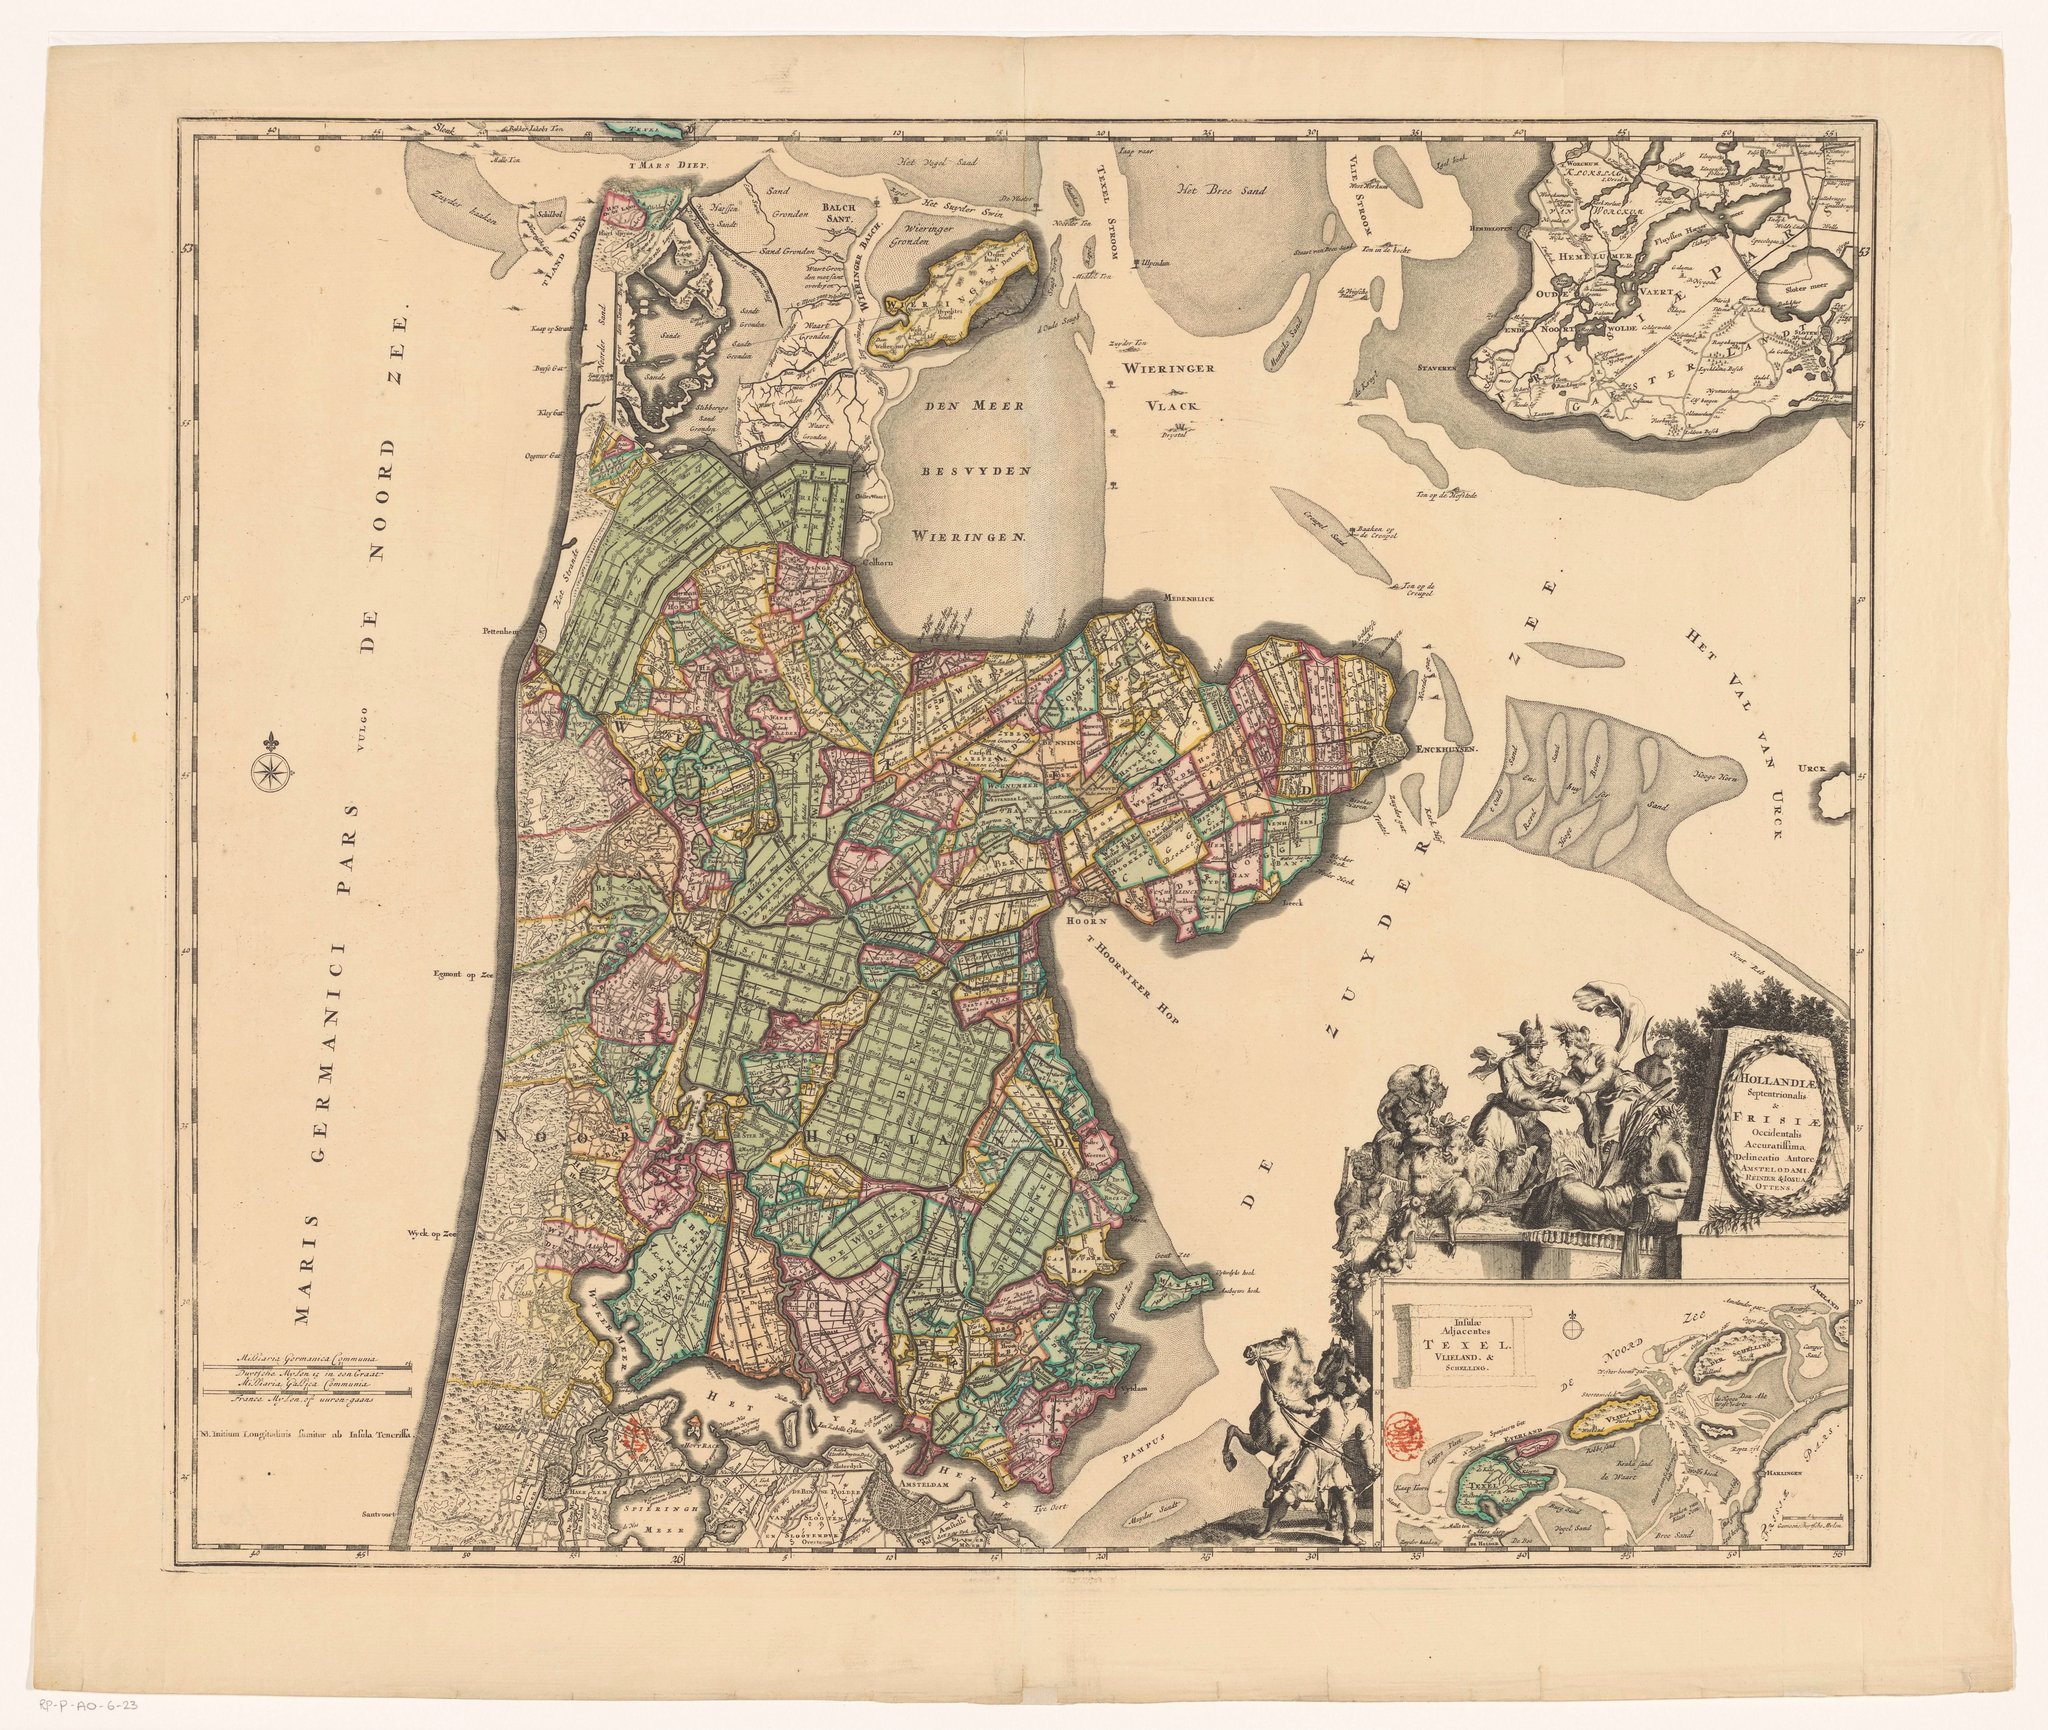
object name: map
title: Kaart van Noord-Holland en een deel van Friesland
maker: Anonymous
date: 1726-1750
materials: paper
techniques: engraving, etching, hand coloring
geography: amsterdam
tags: 'cornucopia', horn of plenty, maps of separate countries or regions, (story of) mercury (hermes), river-gods, satyr(s) (in general)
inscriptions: collector's mark: Lugt 195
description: Linksonder twee schaalstokken: Milliaria Germanica communia / Duytsche mylen 15 in een graat; Milliaria Gallica communia / France mylen, of uuren gaans. Rechtsonder de titelcartouche met daaromheen verschillende figuren waaronder een man met een paard, saters, putti, Mercurius die de hoorn des overvloeds aanneemt van een vrouwfiguur, en een riviergod. Daaronder een inzetkaart van het Waddengebied met een schaalstok: Gemeene Duytsche mylen. Gradenverdeling langs de randen.